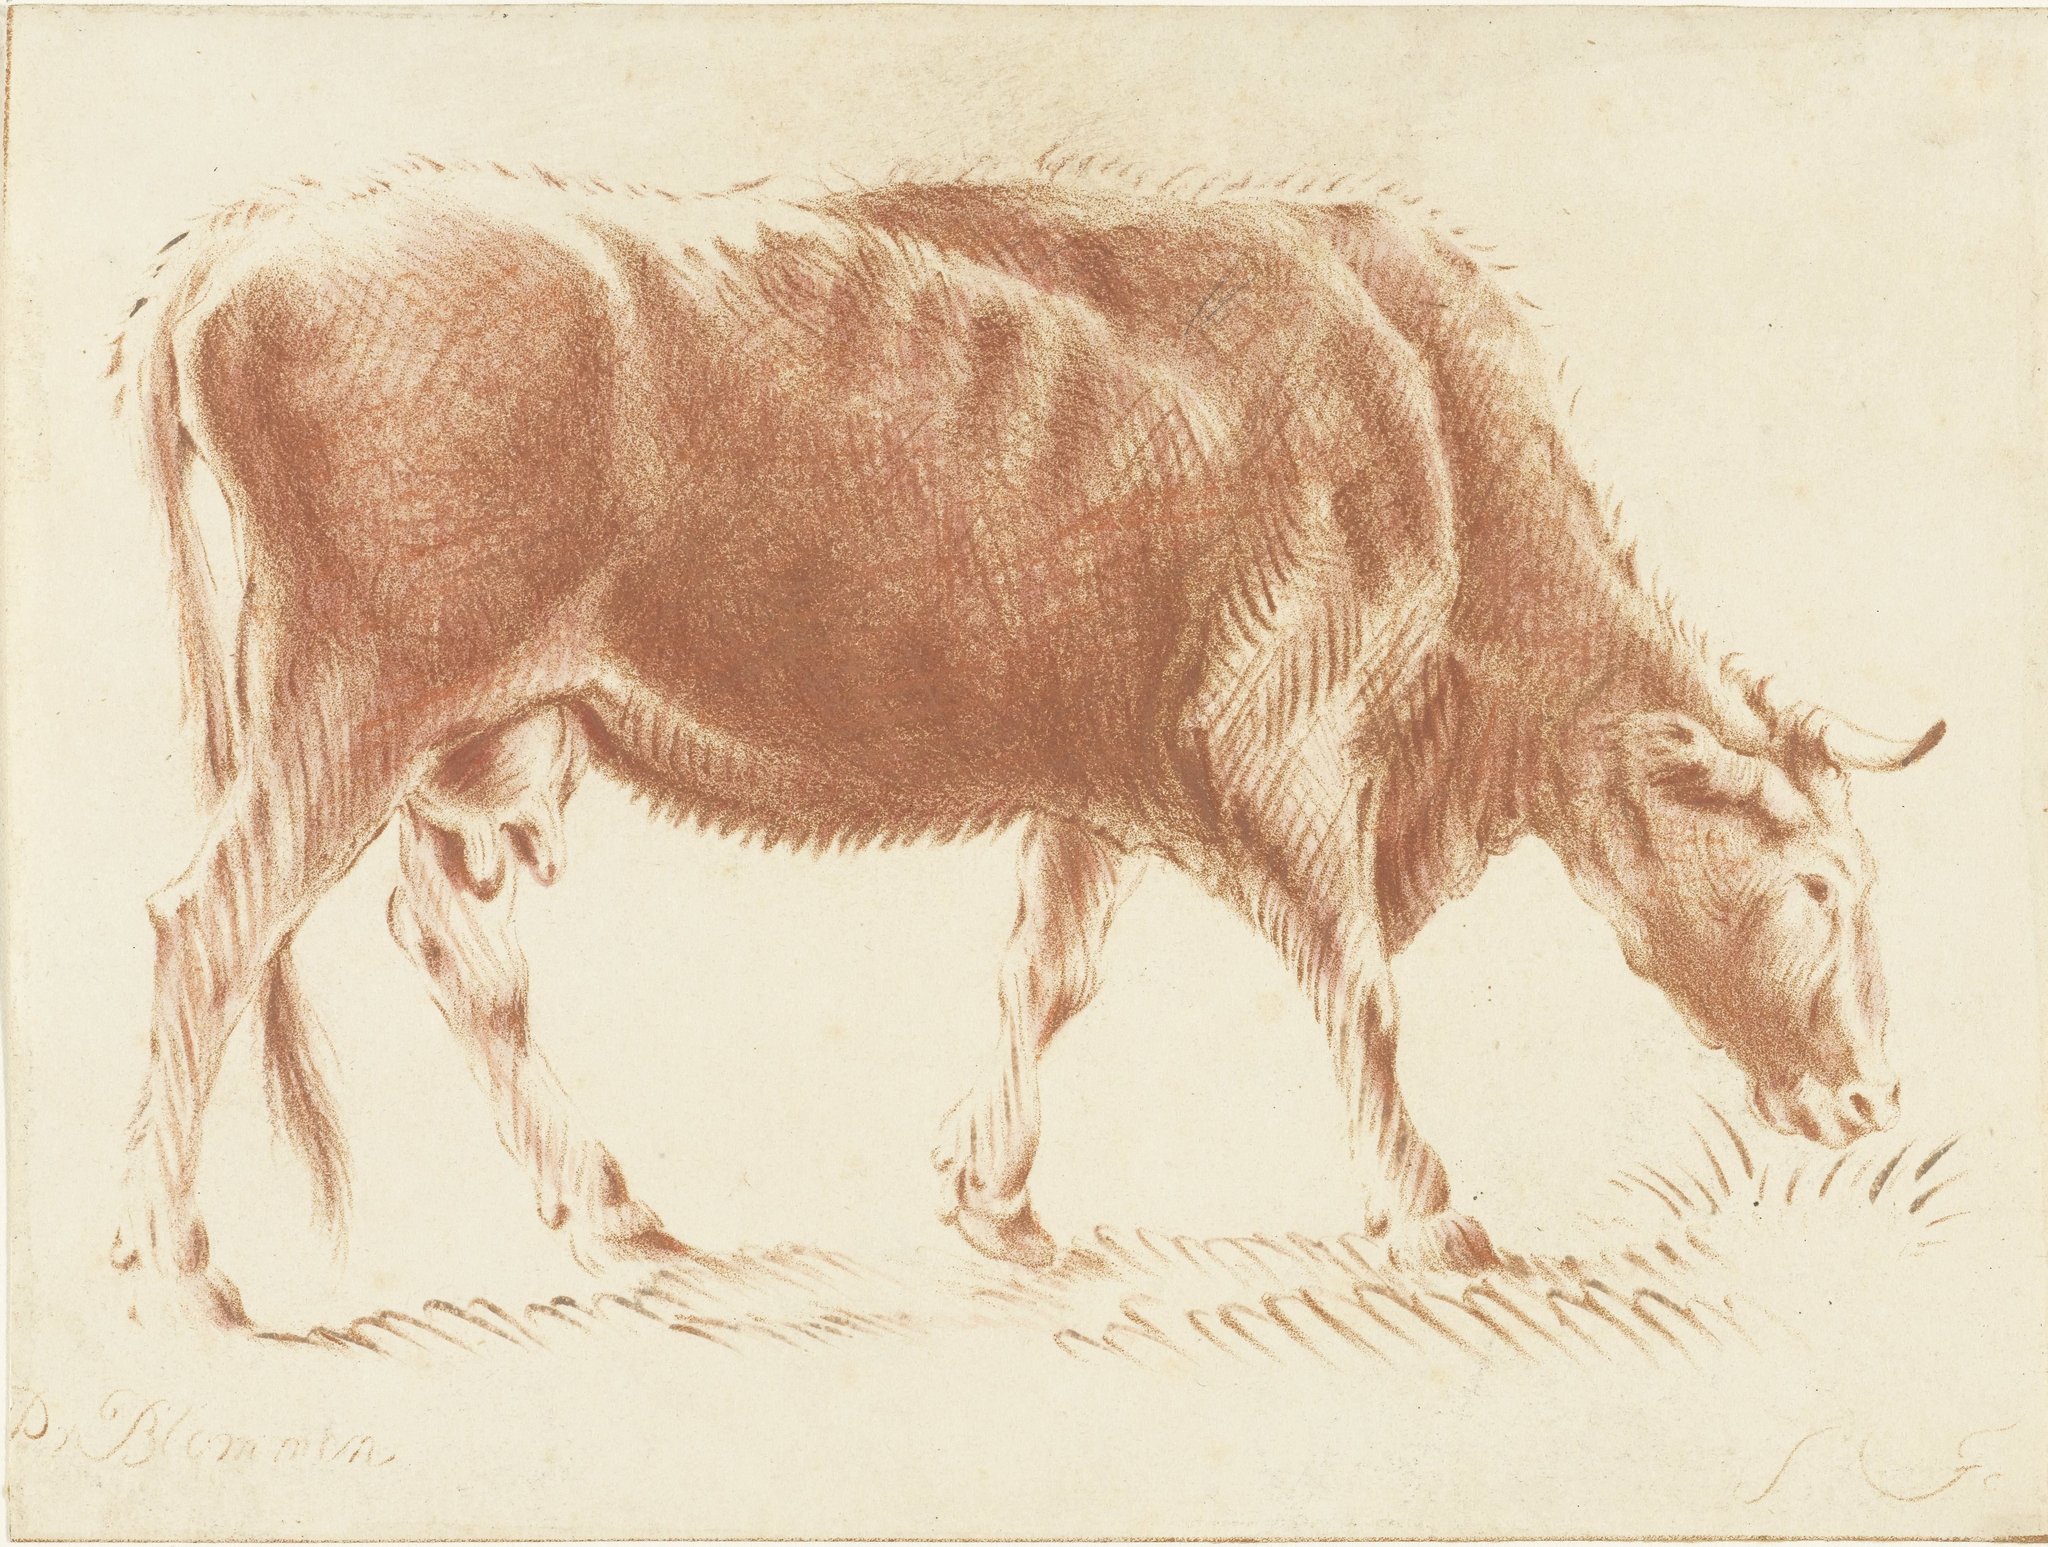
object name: print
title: Grazende koe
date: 1724-1798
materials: paper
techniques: printmaking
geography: antwerp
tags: cow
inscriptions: collector's mark